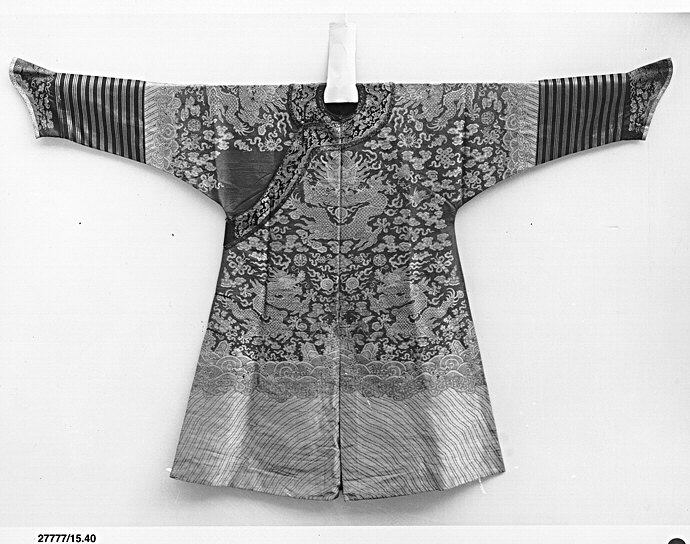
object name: robe, imperial court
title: Court Robe, Imperial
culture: chinese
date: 1801-1900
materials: metal thread, silk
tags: dragons